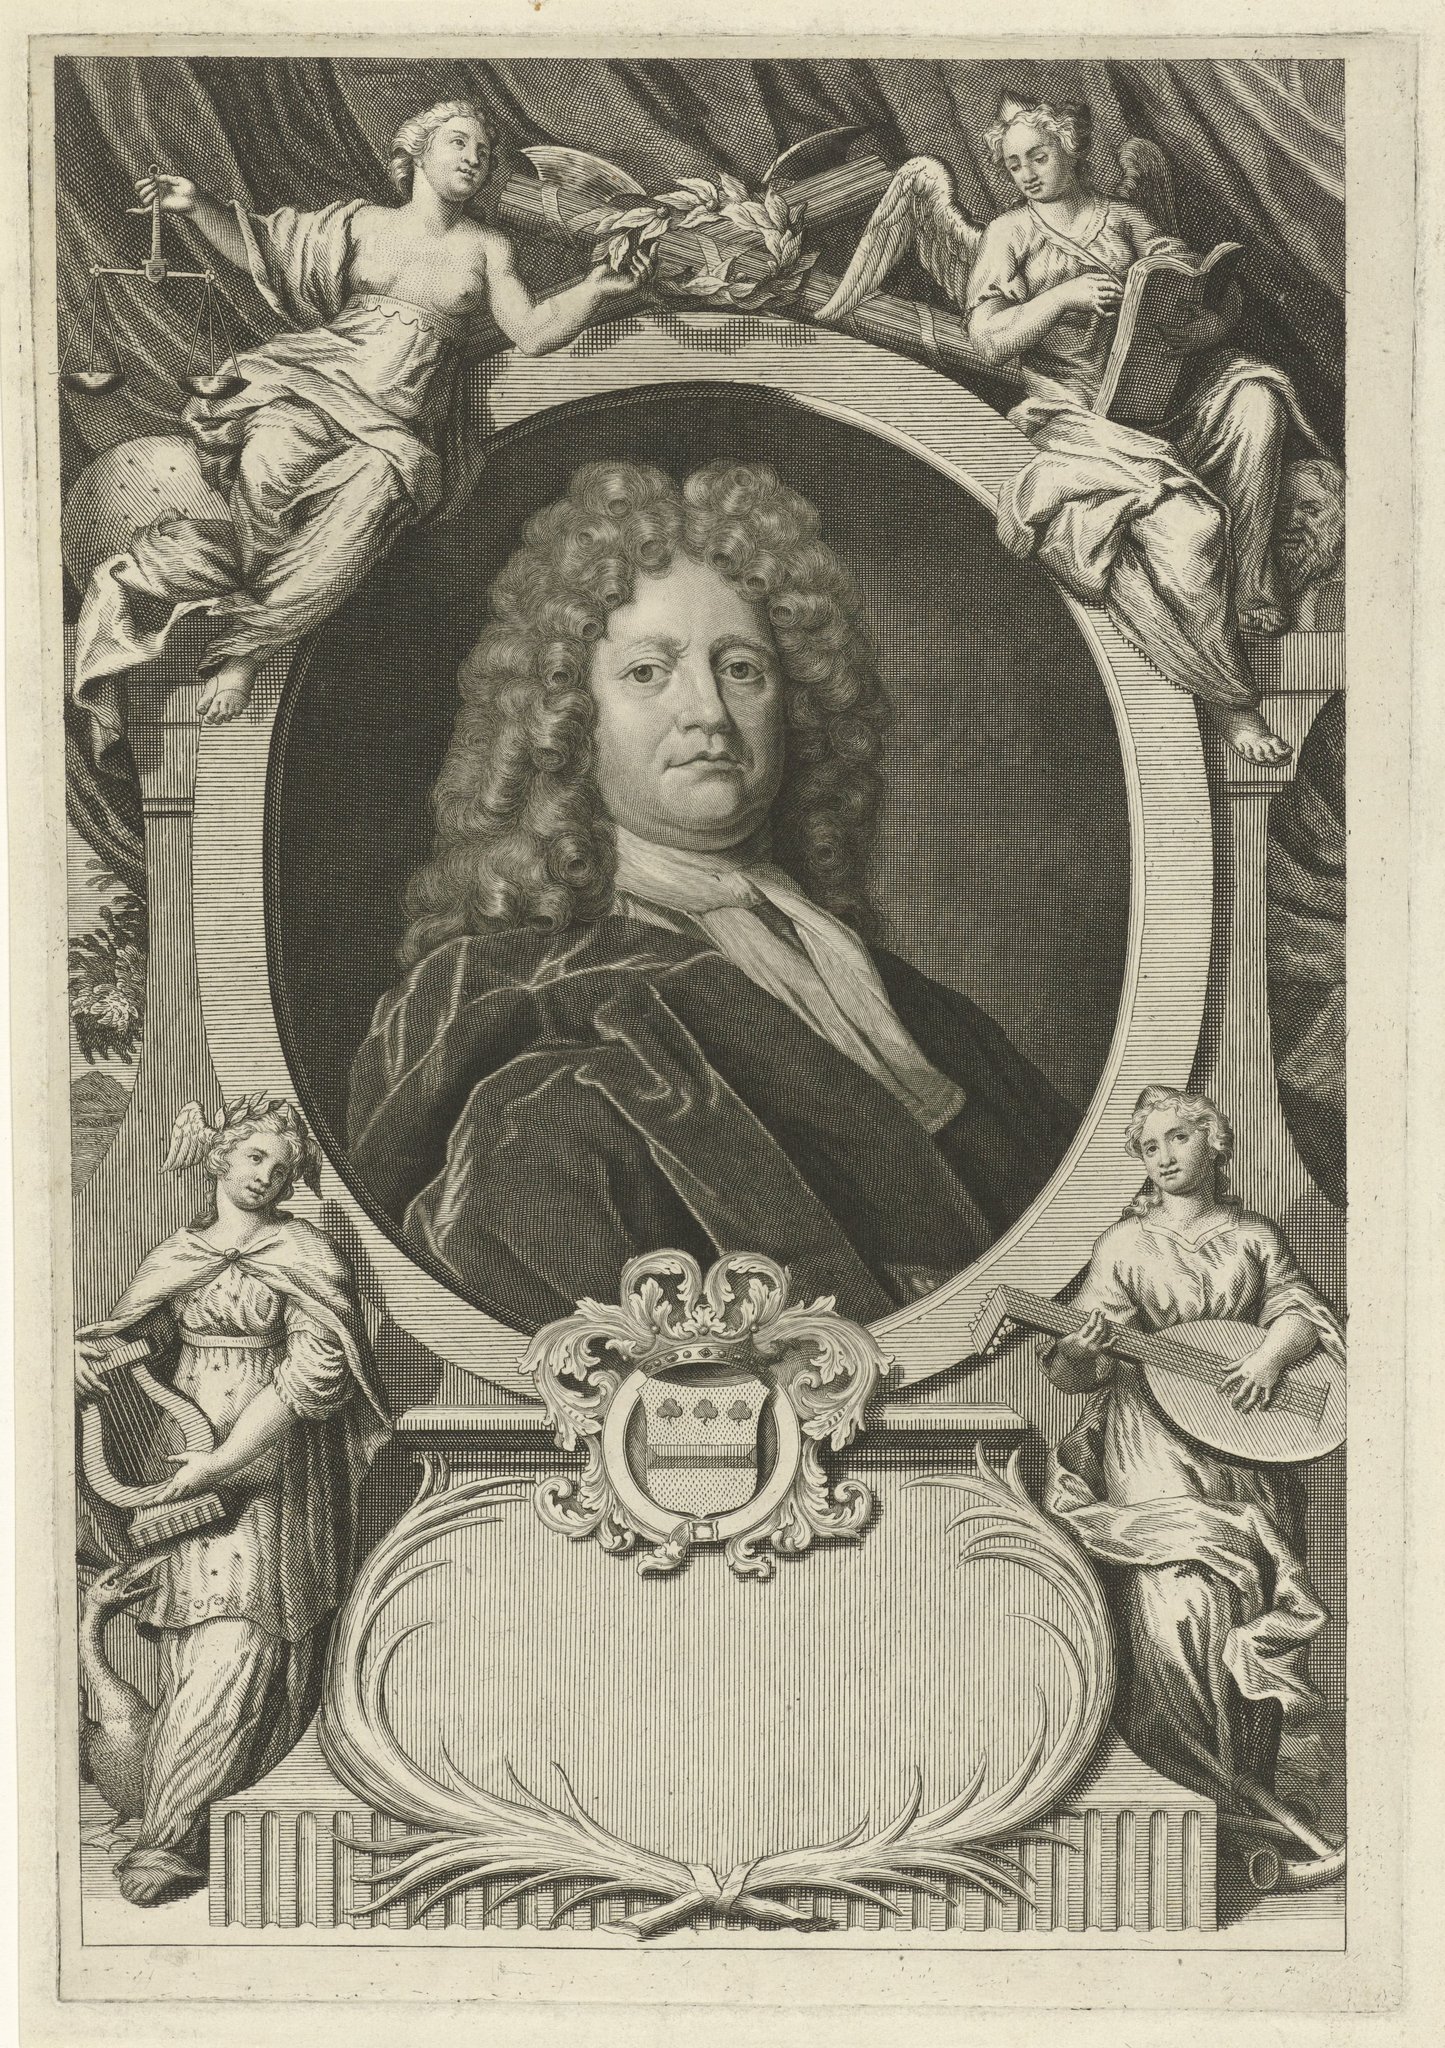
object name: print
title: Portret van Alexander de Muncq op 55-jarige leeftijd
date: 1710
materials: paper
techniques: engraving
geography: amsterdam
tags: mayor, making music; musician with instrument, truth; 'verità' (ripa), justice; 'forza alla giustitia sottoposta', 'giustitia', 'giustitia retta', 'giustitia rigorosa', 'impietà e violenza soggetta alla giustitia' (ripa), harp, dulcimer, zither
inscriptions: collector's mark: Lugt 2228, collector's mark: Lugt 240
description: Alexander de Muncq, burgemeester van Middelburg en dichter, op 55-jarige leeftijd. Onder het portret zijn wapenschild. Boven het portret de personificaties van Rechtvaardigheid en Waarheid, die hem met een lauwerkrans kronen. Onder het portret spelen twee muzen de lier en de citer.